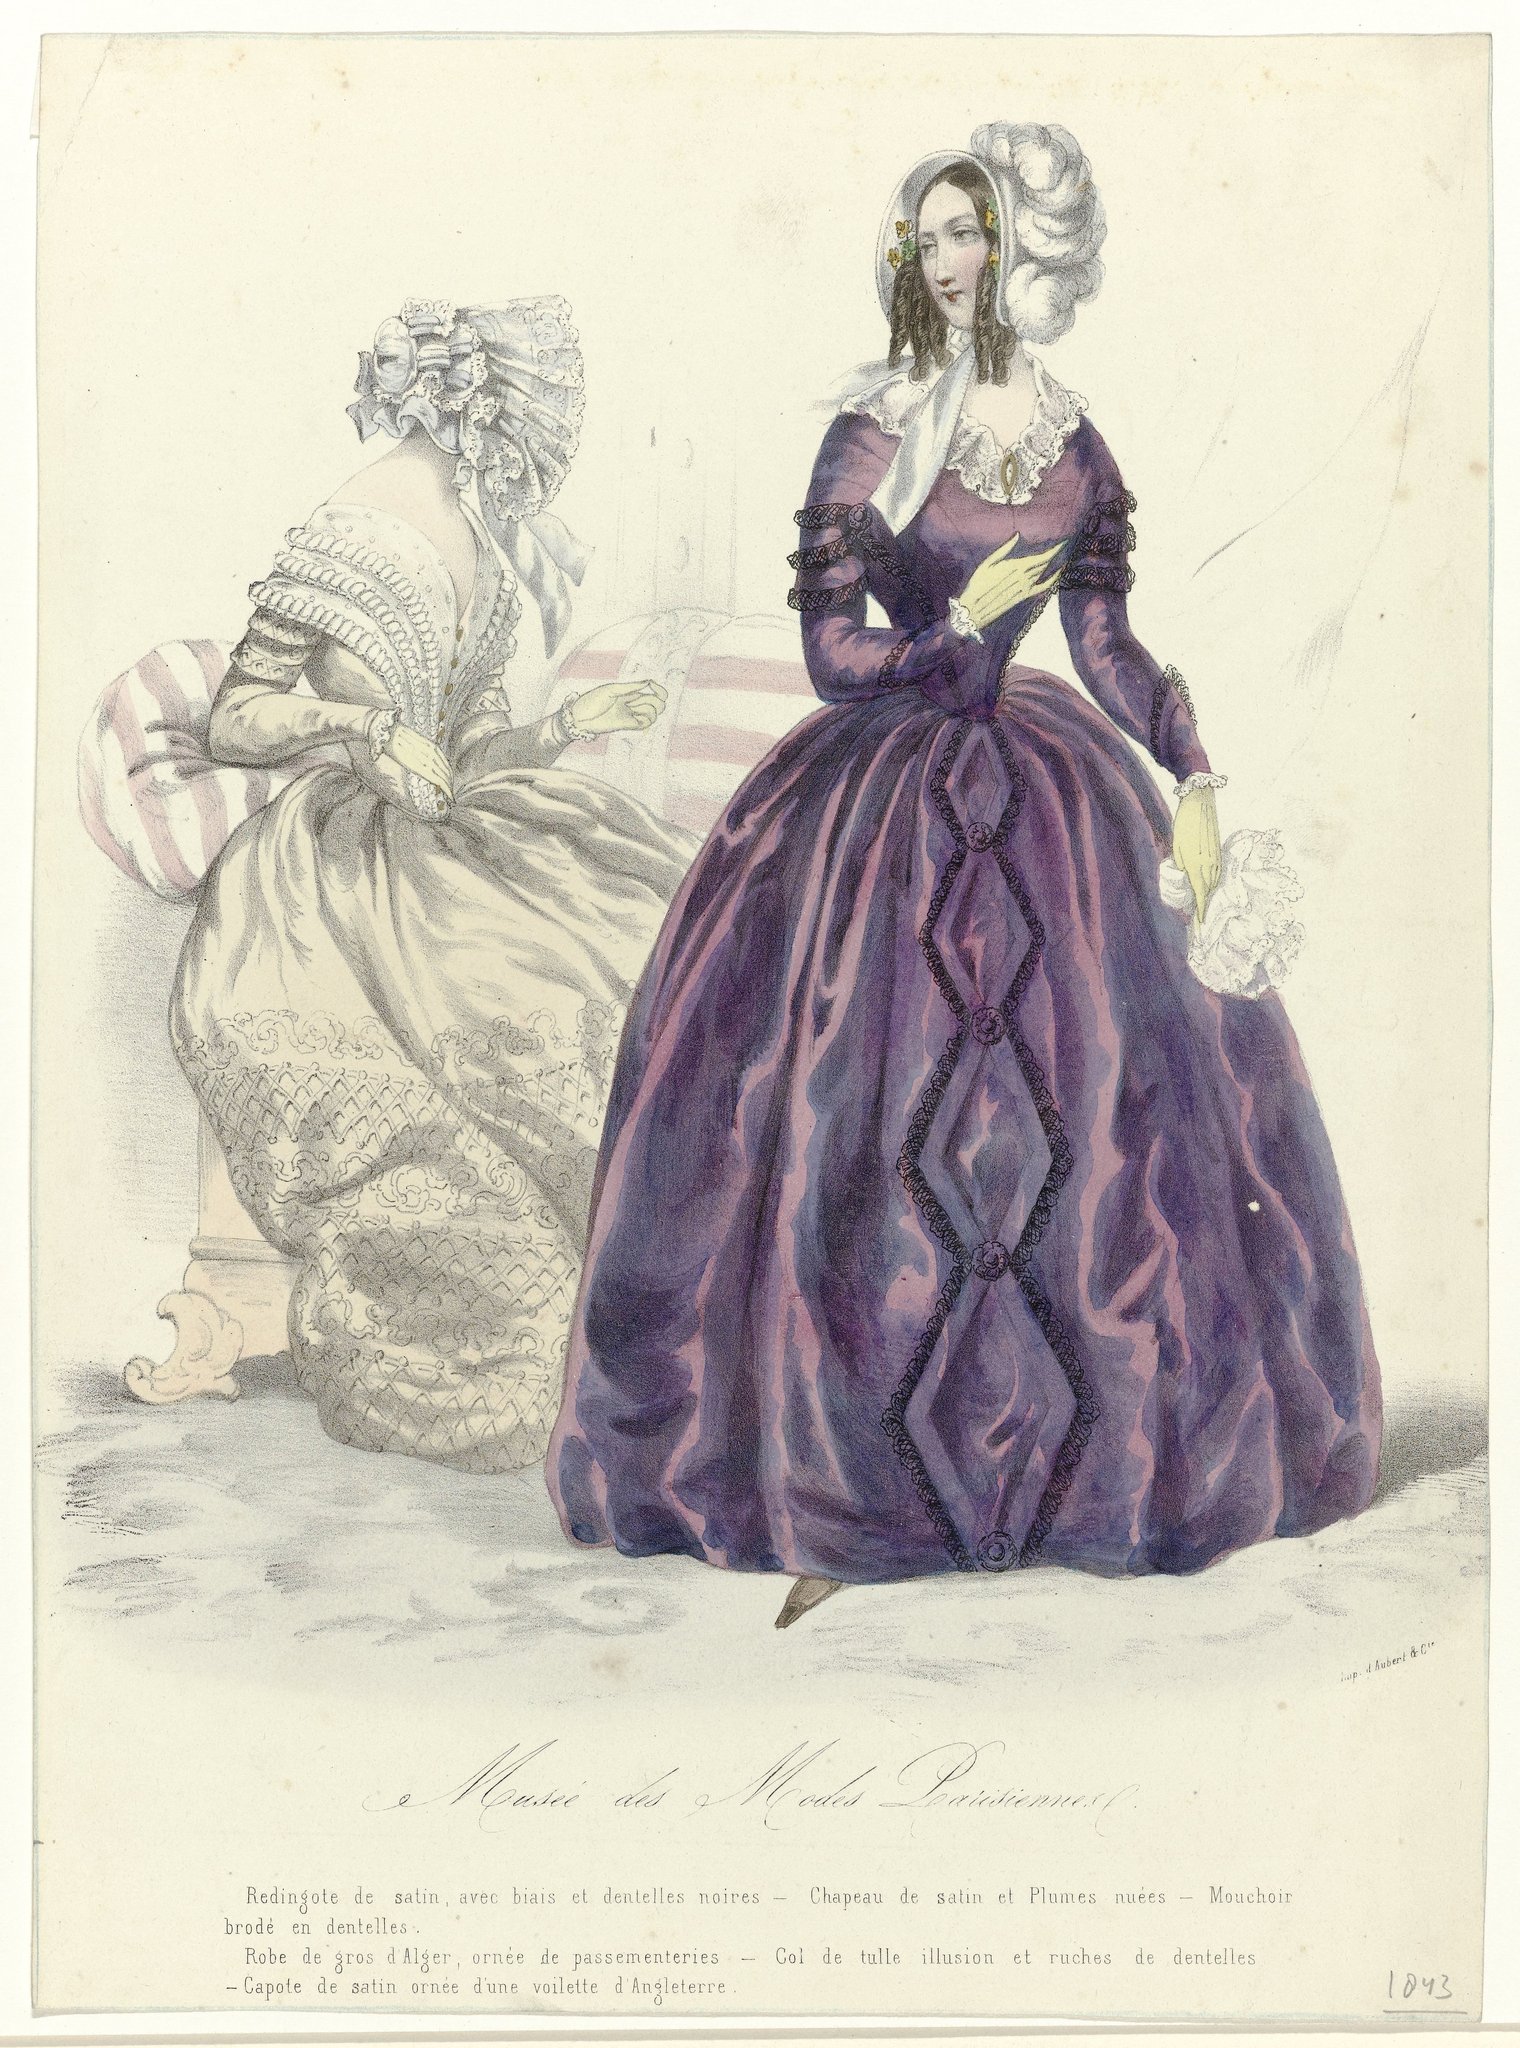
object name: fashion print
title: Musée des Modes Parisiennes, 1843 : Redingote de satin (...)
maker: Anonymous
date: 1843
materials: paper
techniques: hand coloring, lithograph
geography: paris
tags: handkerchief (+ women's clothes), brooch, agraffe, clasp (+ women's clothes), head-gear (capote) (+ women's clothes), ornamental parts of clothing (+ women's clothes), veil (+ women's clothes), dress, gown: redingote (+ women's clothes), fashion plates, shoes, sandals (+ women's clothes), gloves, mittens, etc. (+ women's clothes), dress, gown (+ women's clothes), neck-gear ~ clothing (+ women's clothes)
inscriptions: title: ‘Musée des Modes Parisiennes’, caption: ‘Redingote de satin avec biais et dentelles noires - Chapeau de satin et Plumes nuées - Mouchoir brodé en dentelles. Robe de gros d'Alger, ornée de passementeries- Col de tulle illusion et ruches de dentelles - Capote de satin ornée d'un violette d'Angleterre.’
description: Twee vrouwen in een interieur. Links: japon van 'gros d'Alger', versierd met passementen. Kraag van 'tulle illusion' en ruches van kant. Capote van satijn, versierd met een voile van 'Angleterre'. Rechts: redingote van satijn, met biaisband en zwart kant. Luifelhoed van satijn met veren. Zakdoek met borduurwerk en kant. Prent uit het modetijdschrift Musée des Modes Parisiennes (5 maart 1843 tot 29 oktober 1843).